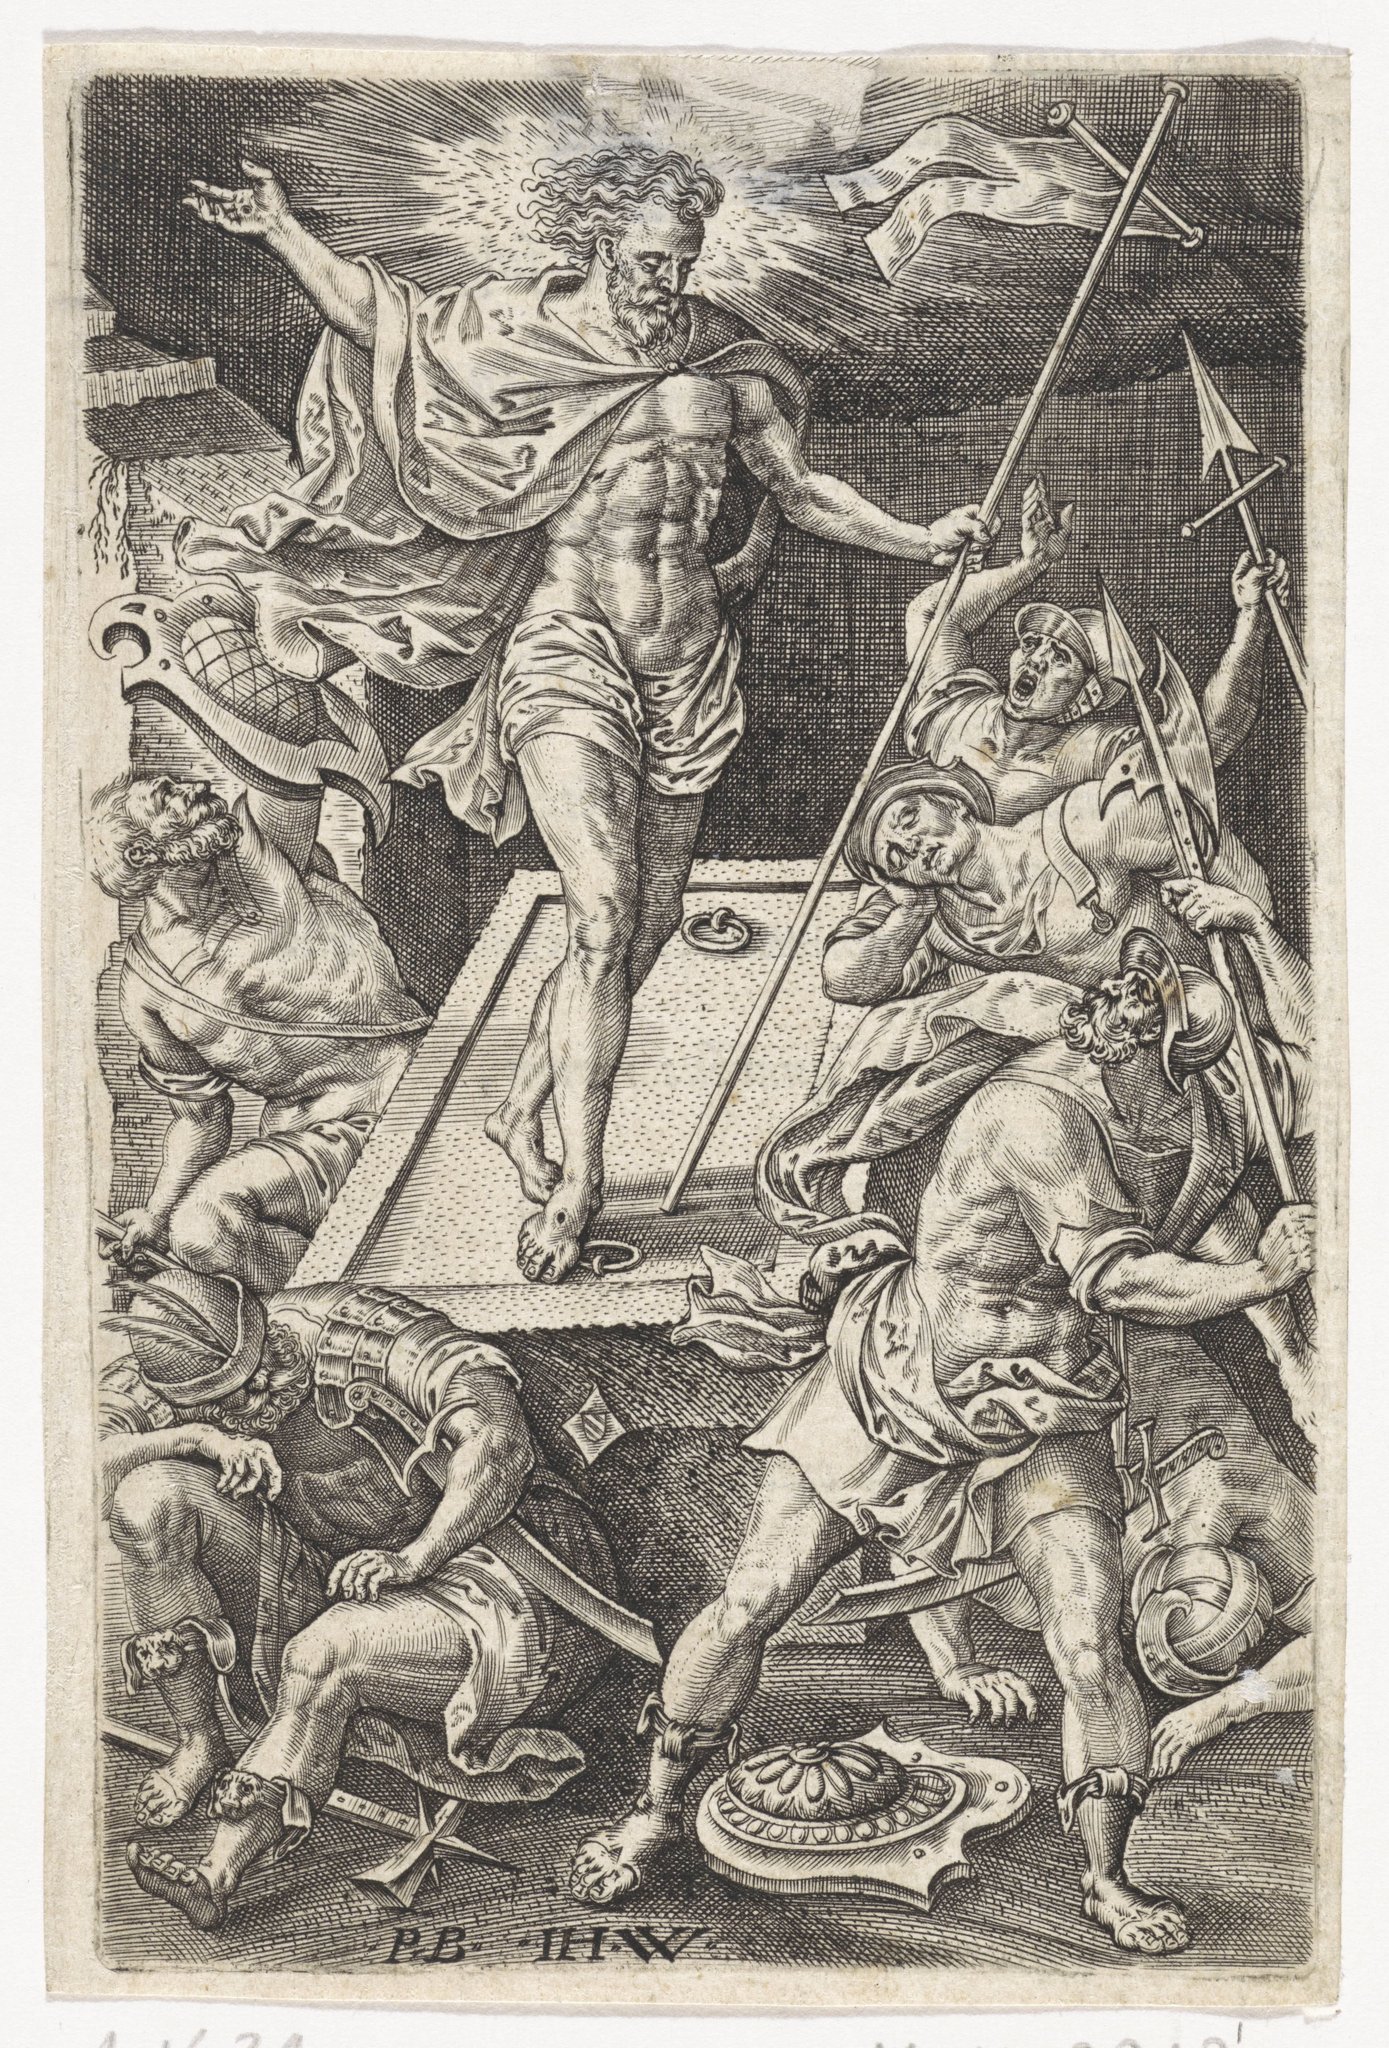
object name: book illustration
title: Opstanding van Christus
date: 1570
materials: paper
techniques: engraving, letterpress printing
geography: antwerp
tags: christ, usually holding a banner, arises from the grave; often combined with sleeping and/or frightened soldiers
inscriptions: collector's mark: Lugt 2228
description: Christus verrijst uit zijn graf. De soldaten die rondom het graf liggen schrikken wakker en vluchten.